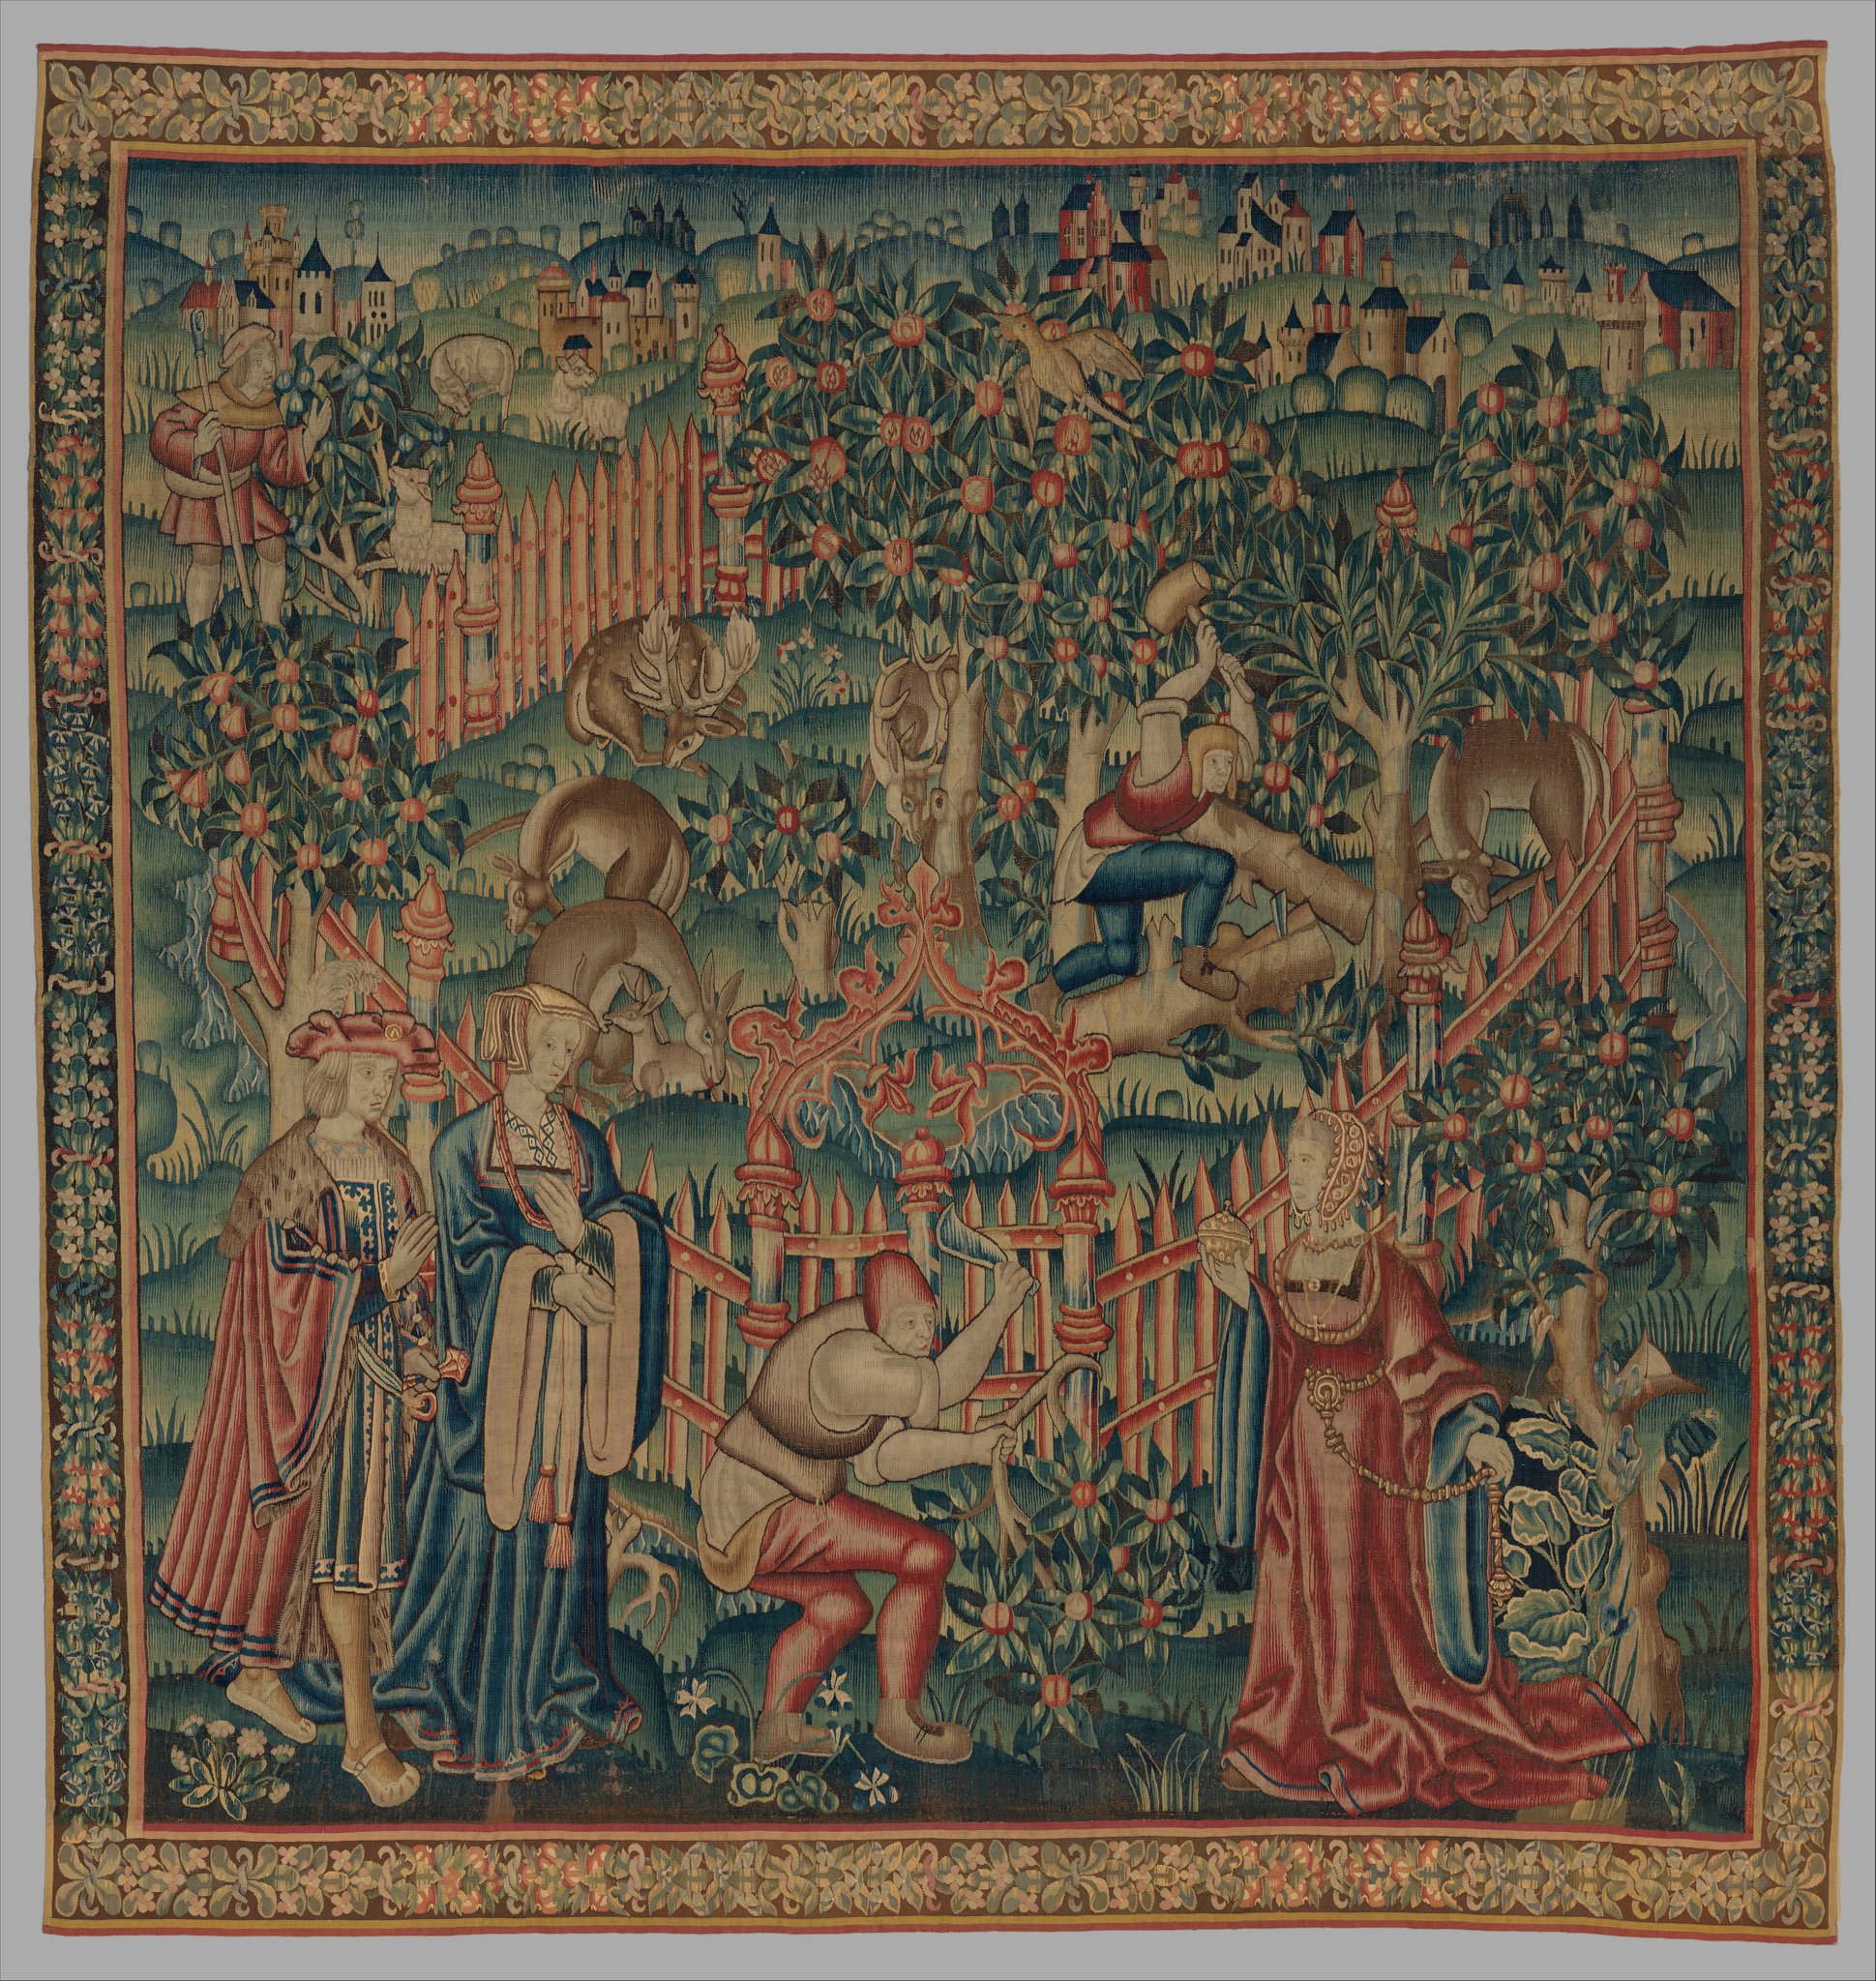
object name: tapestry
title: Woodcutters Working at a Deer Park (from the Hunting Parks Tapestries)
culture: south netherlandish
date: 1515-1535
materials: thread, wool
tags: men,women,deer,working